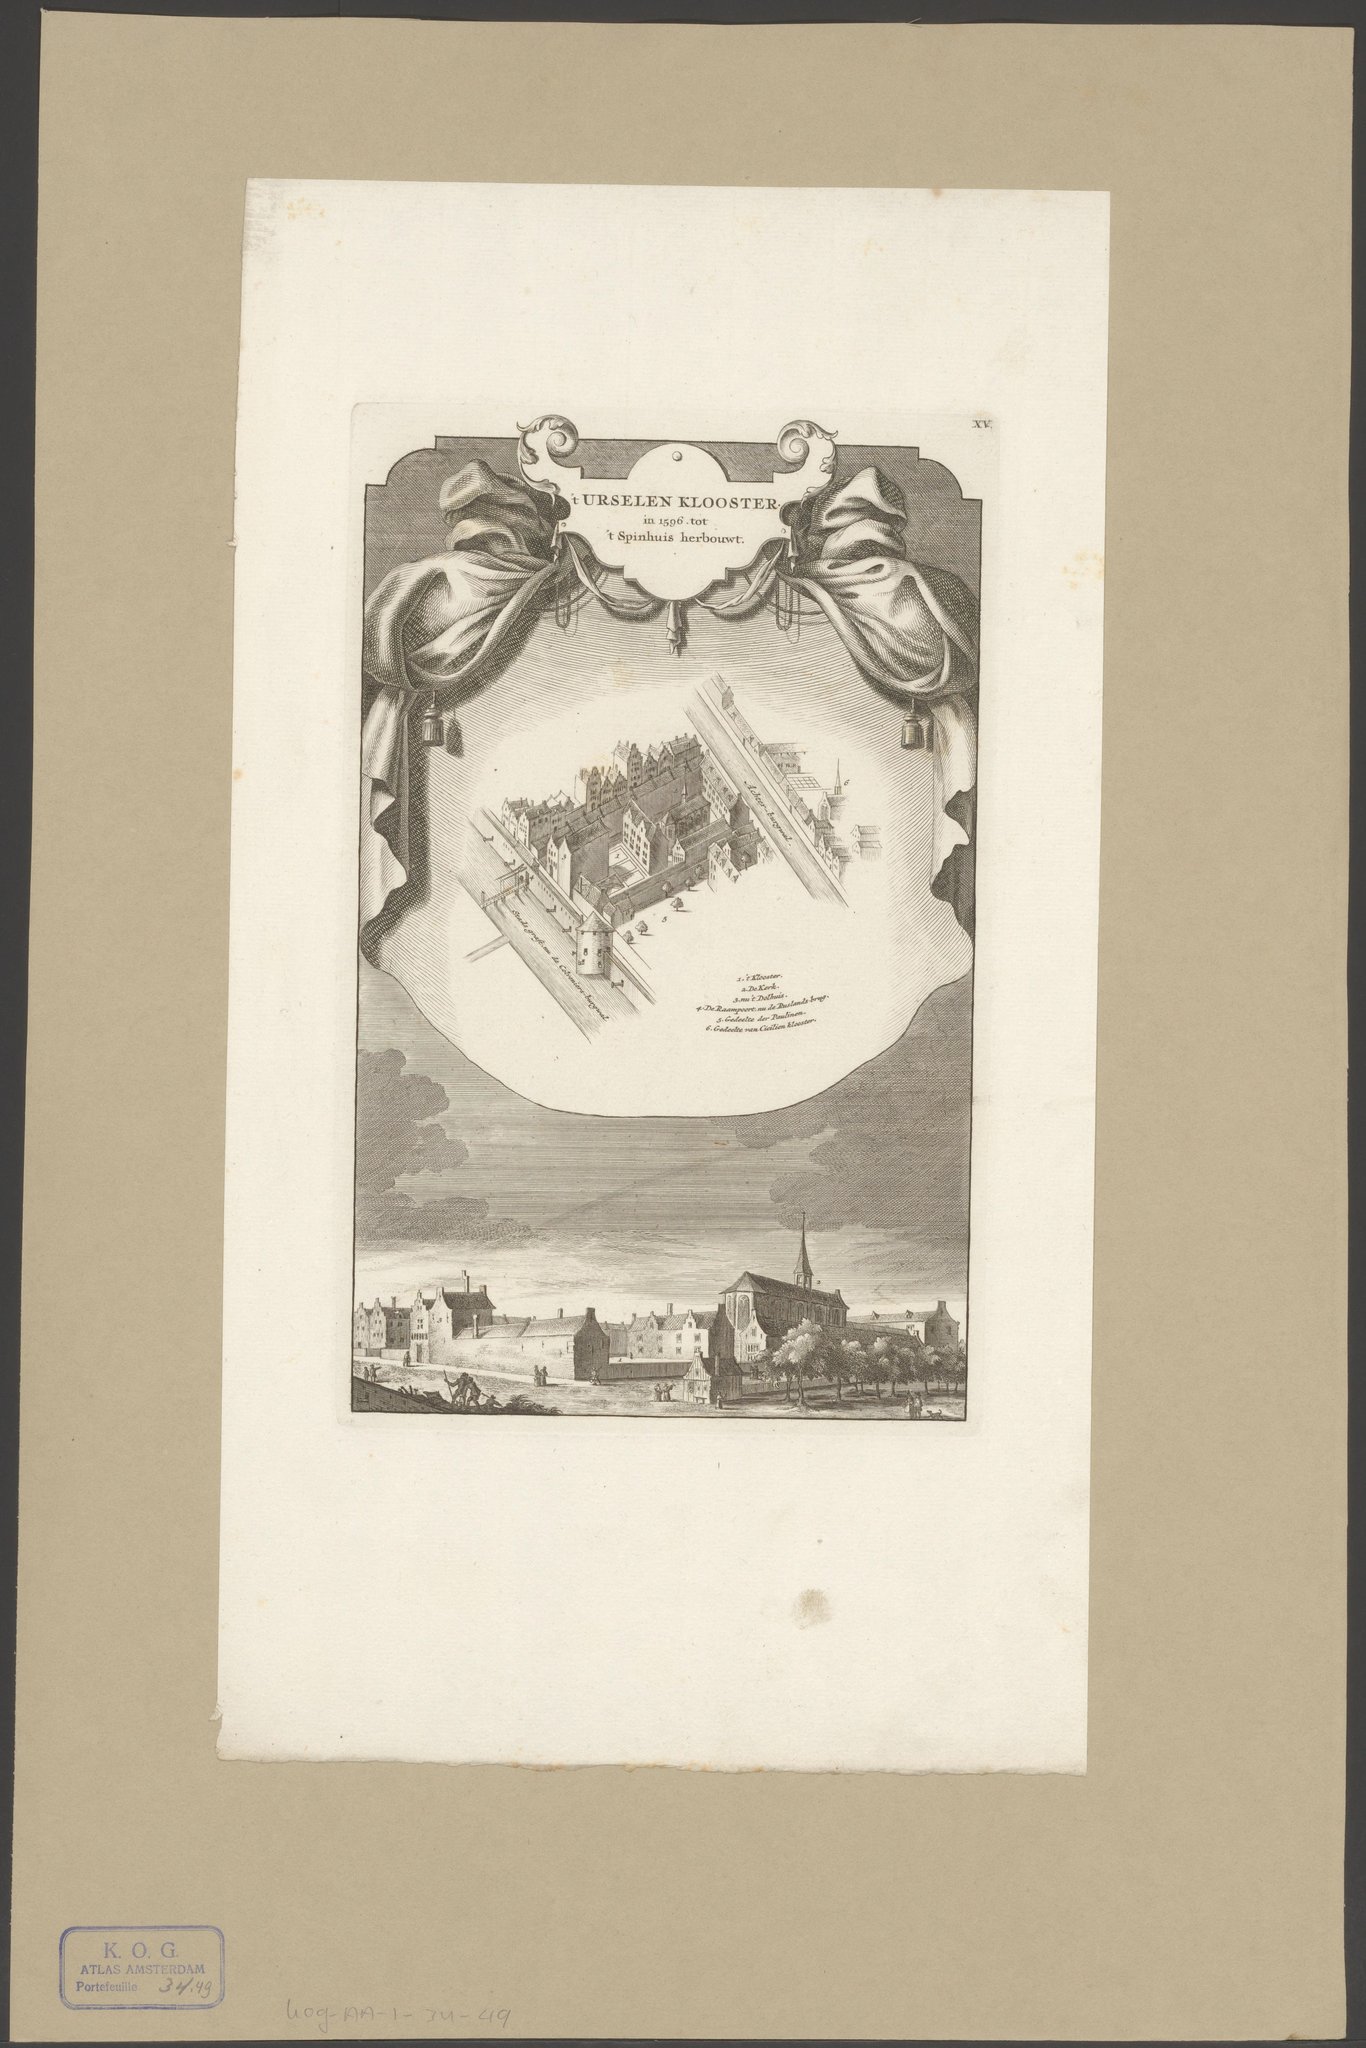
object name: print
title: 't Urselen Klooster in 1596 tot 't Spinhuis herbouwt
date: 1760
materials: paper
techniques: engraving, etching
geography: amsterdam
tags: abbey, monastery, convent ~ roman catholic church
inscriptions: collector's mark: Lugt 1641b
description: Gezicht in vogelvlucht en gezicht op Sint-Ursulaklooster tussen de Oudezijds Achterburgwal en de Kloveniersburgwal te Amsterdam, in de situatie omstreeks 1544. Na de Alteratie is een deel van het gebouw gebruikt voor het Spinhuis. Boven in het midden de titelcartouche. Onder het gezicht in vogelvlucht de legenda 1-6. Rechtsboven genummerd: XV. Onderwerpsrubriek binnen de Atlas Amsterdam: Kerkwezen: R.K. Gemeenten: Kloosters.